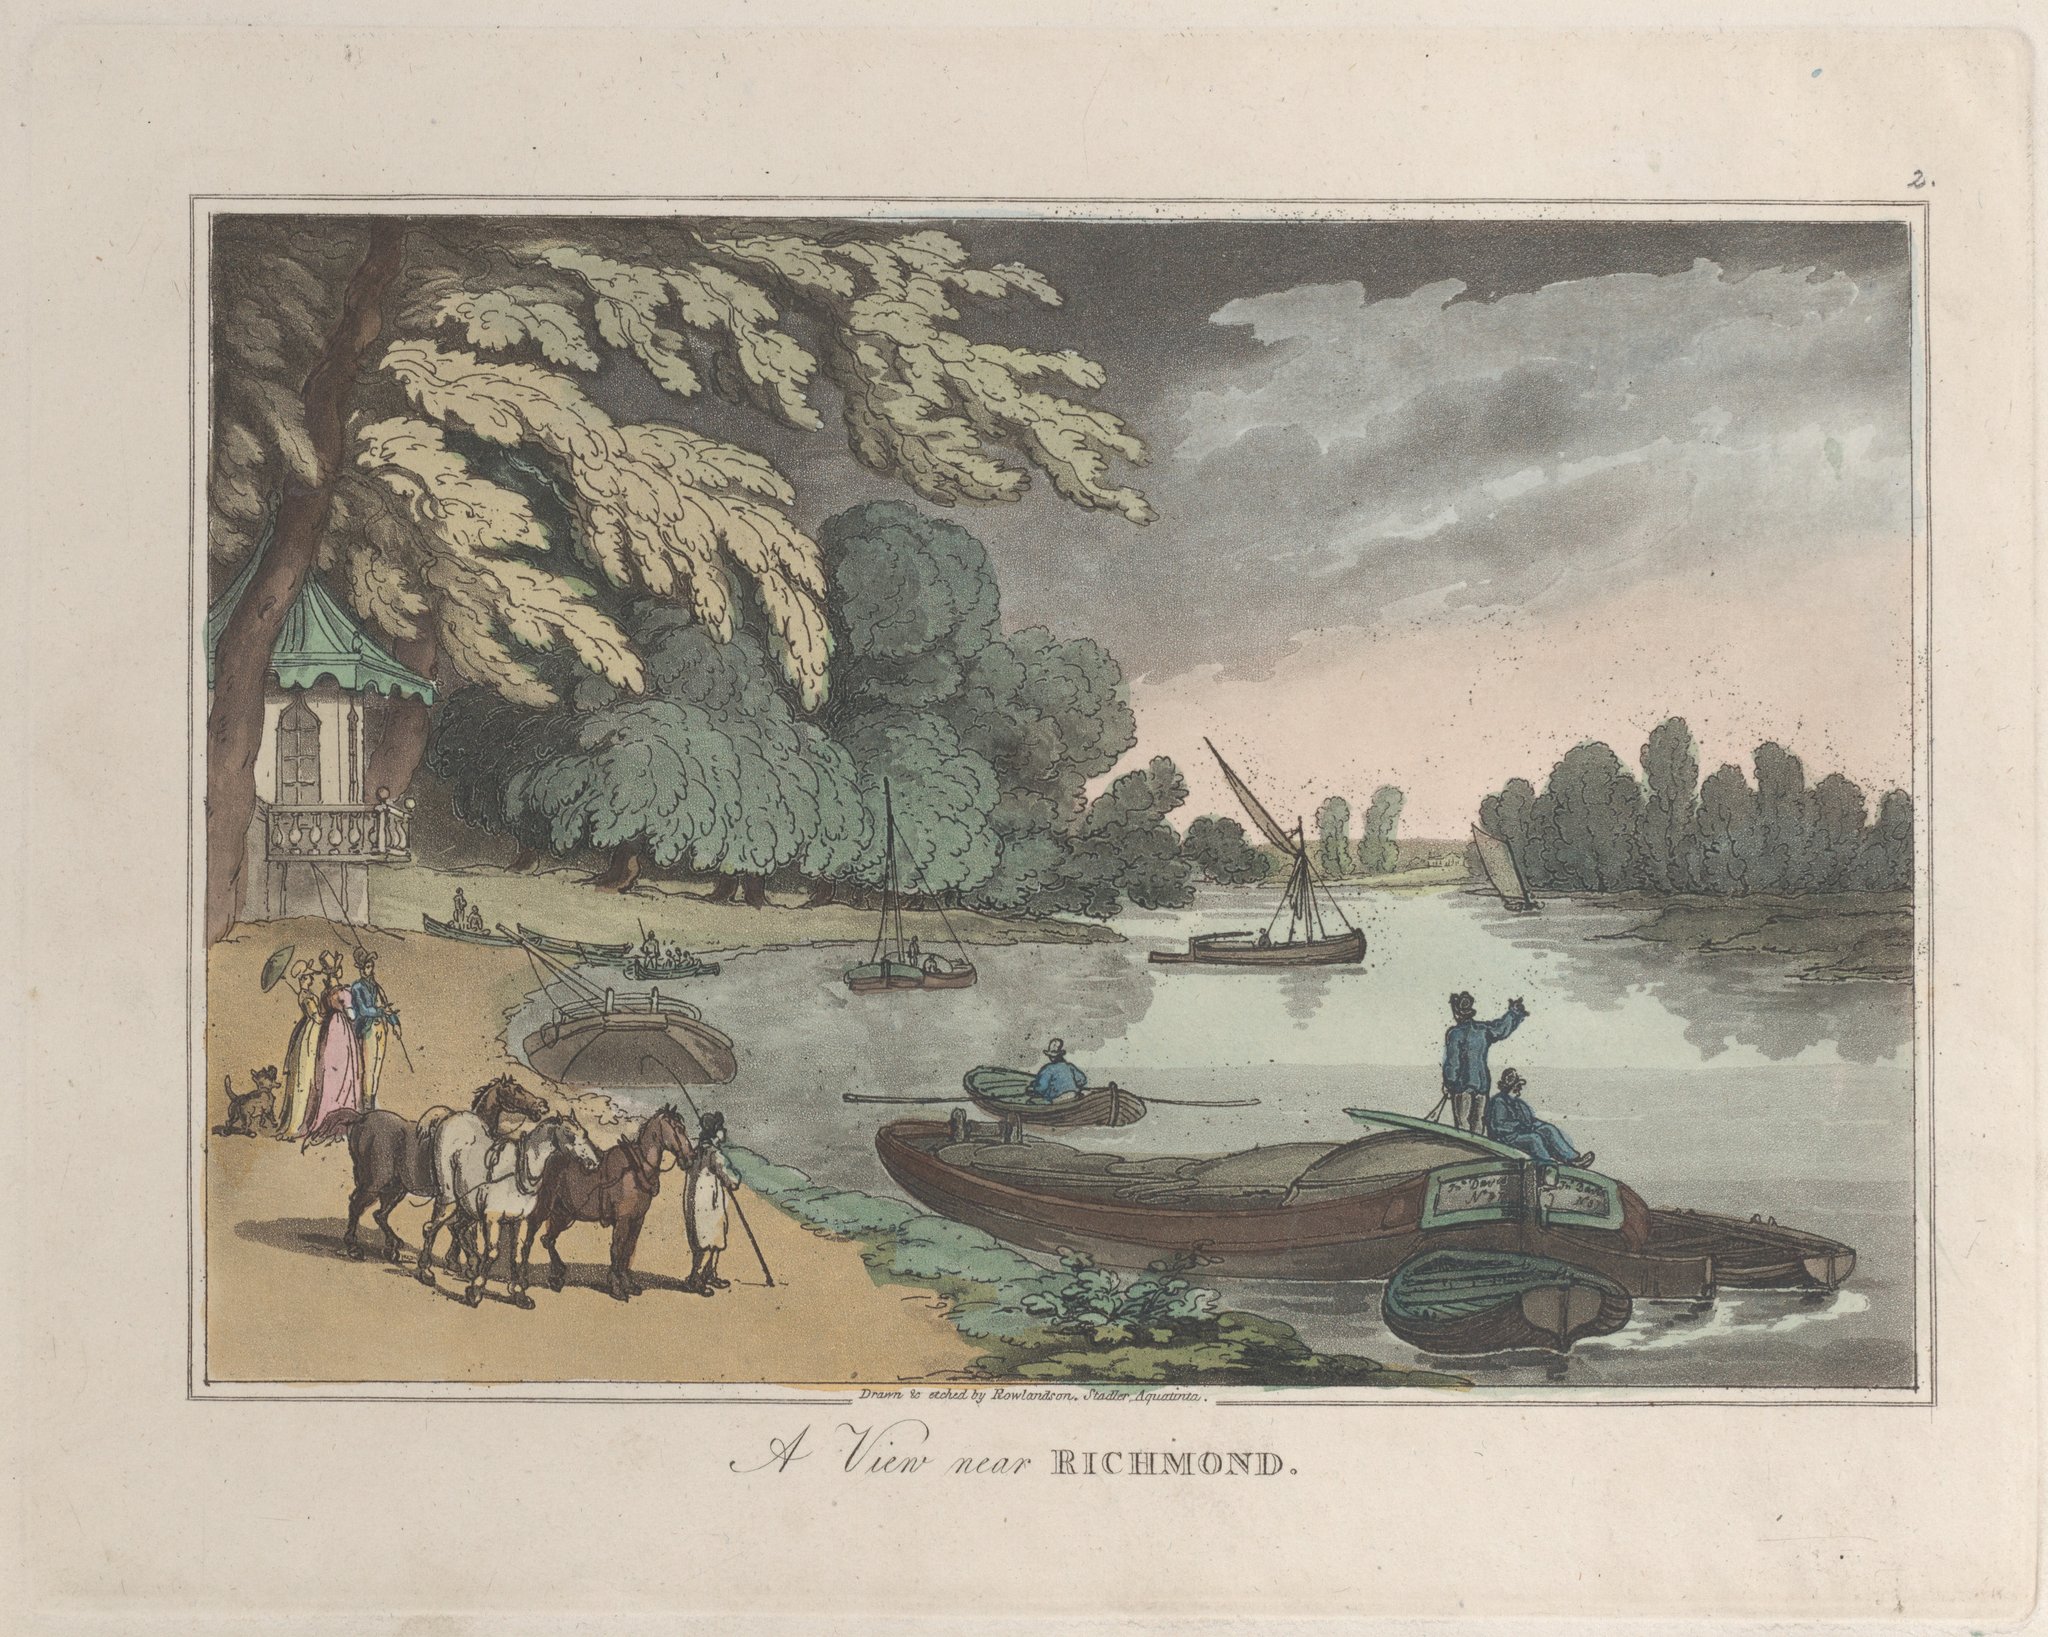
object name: print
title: A View near Richmond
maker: thomas rowlandson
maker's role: artist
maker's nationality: british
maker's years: 1757-1827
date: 1822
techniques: aquatint, etching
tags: horses,rivers,boats